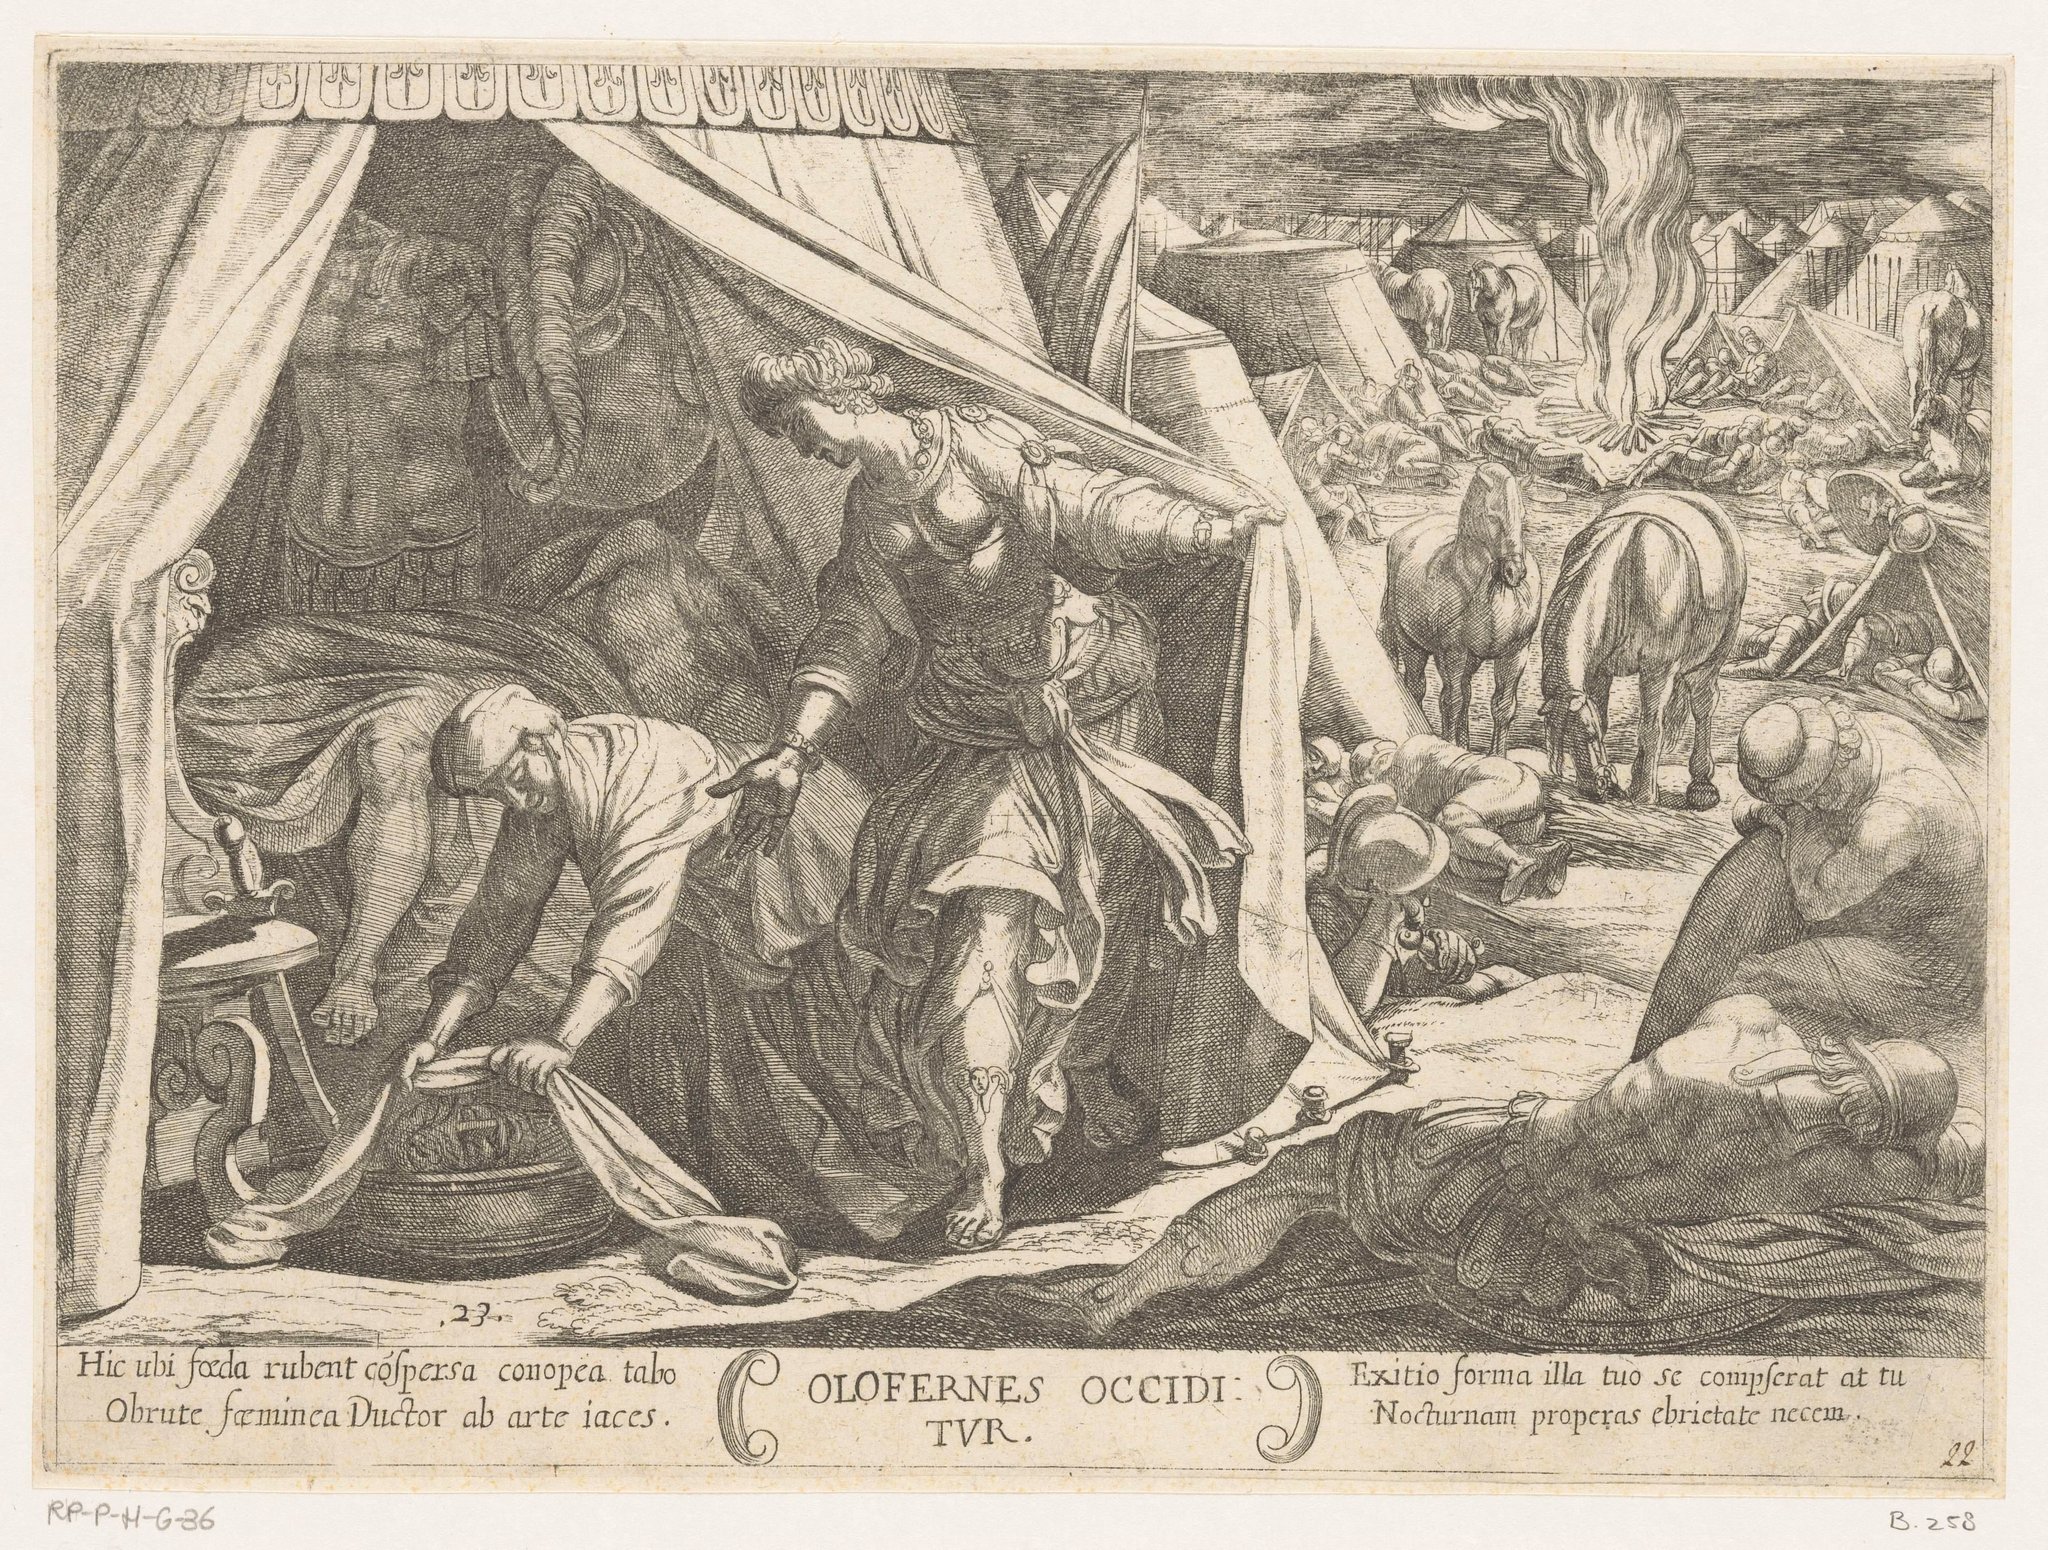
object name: print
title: Olofernes occiditur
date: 1613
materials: paper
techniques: etching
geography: rome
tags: judith and holofernes (judith 8-16), holofernes' head is put on a dish, and covered with a cloth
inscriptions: collector's mark: ‘Hinloopen’, number: ‘22’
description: De dienstmaagd van Judit stopt het afgehakte hoofd van commandant Holofernes in een schaal. Judit houdt het tentdoek open. Rechts liggen de soldaten te slapen rond het vuur. Titel en onderschrift in het Latijn in de ondermarge.